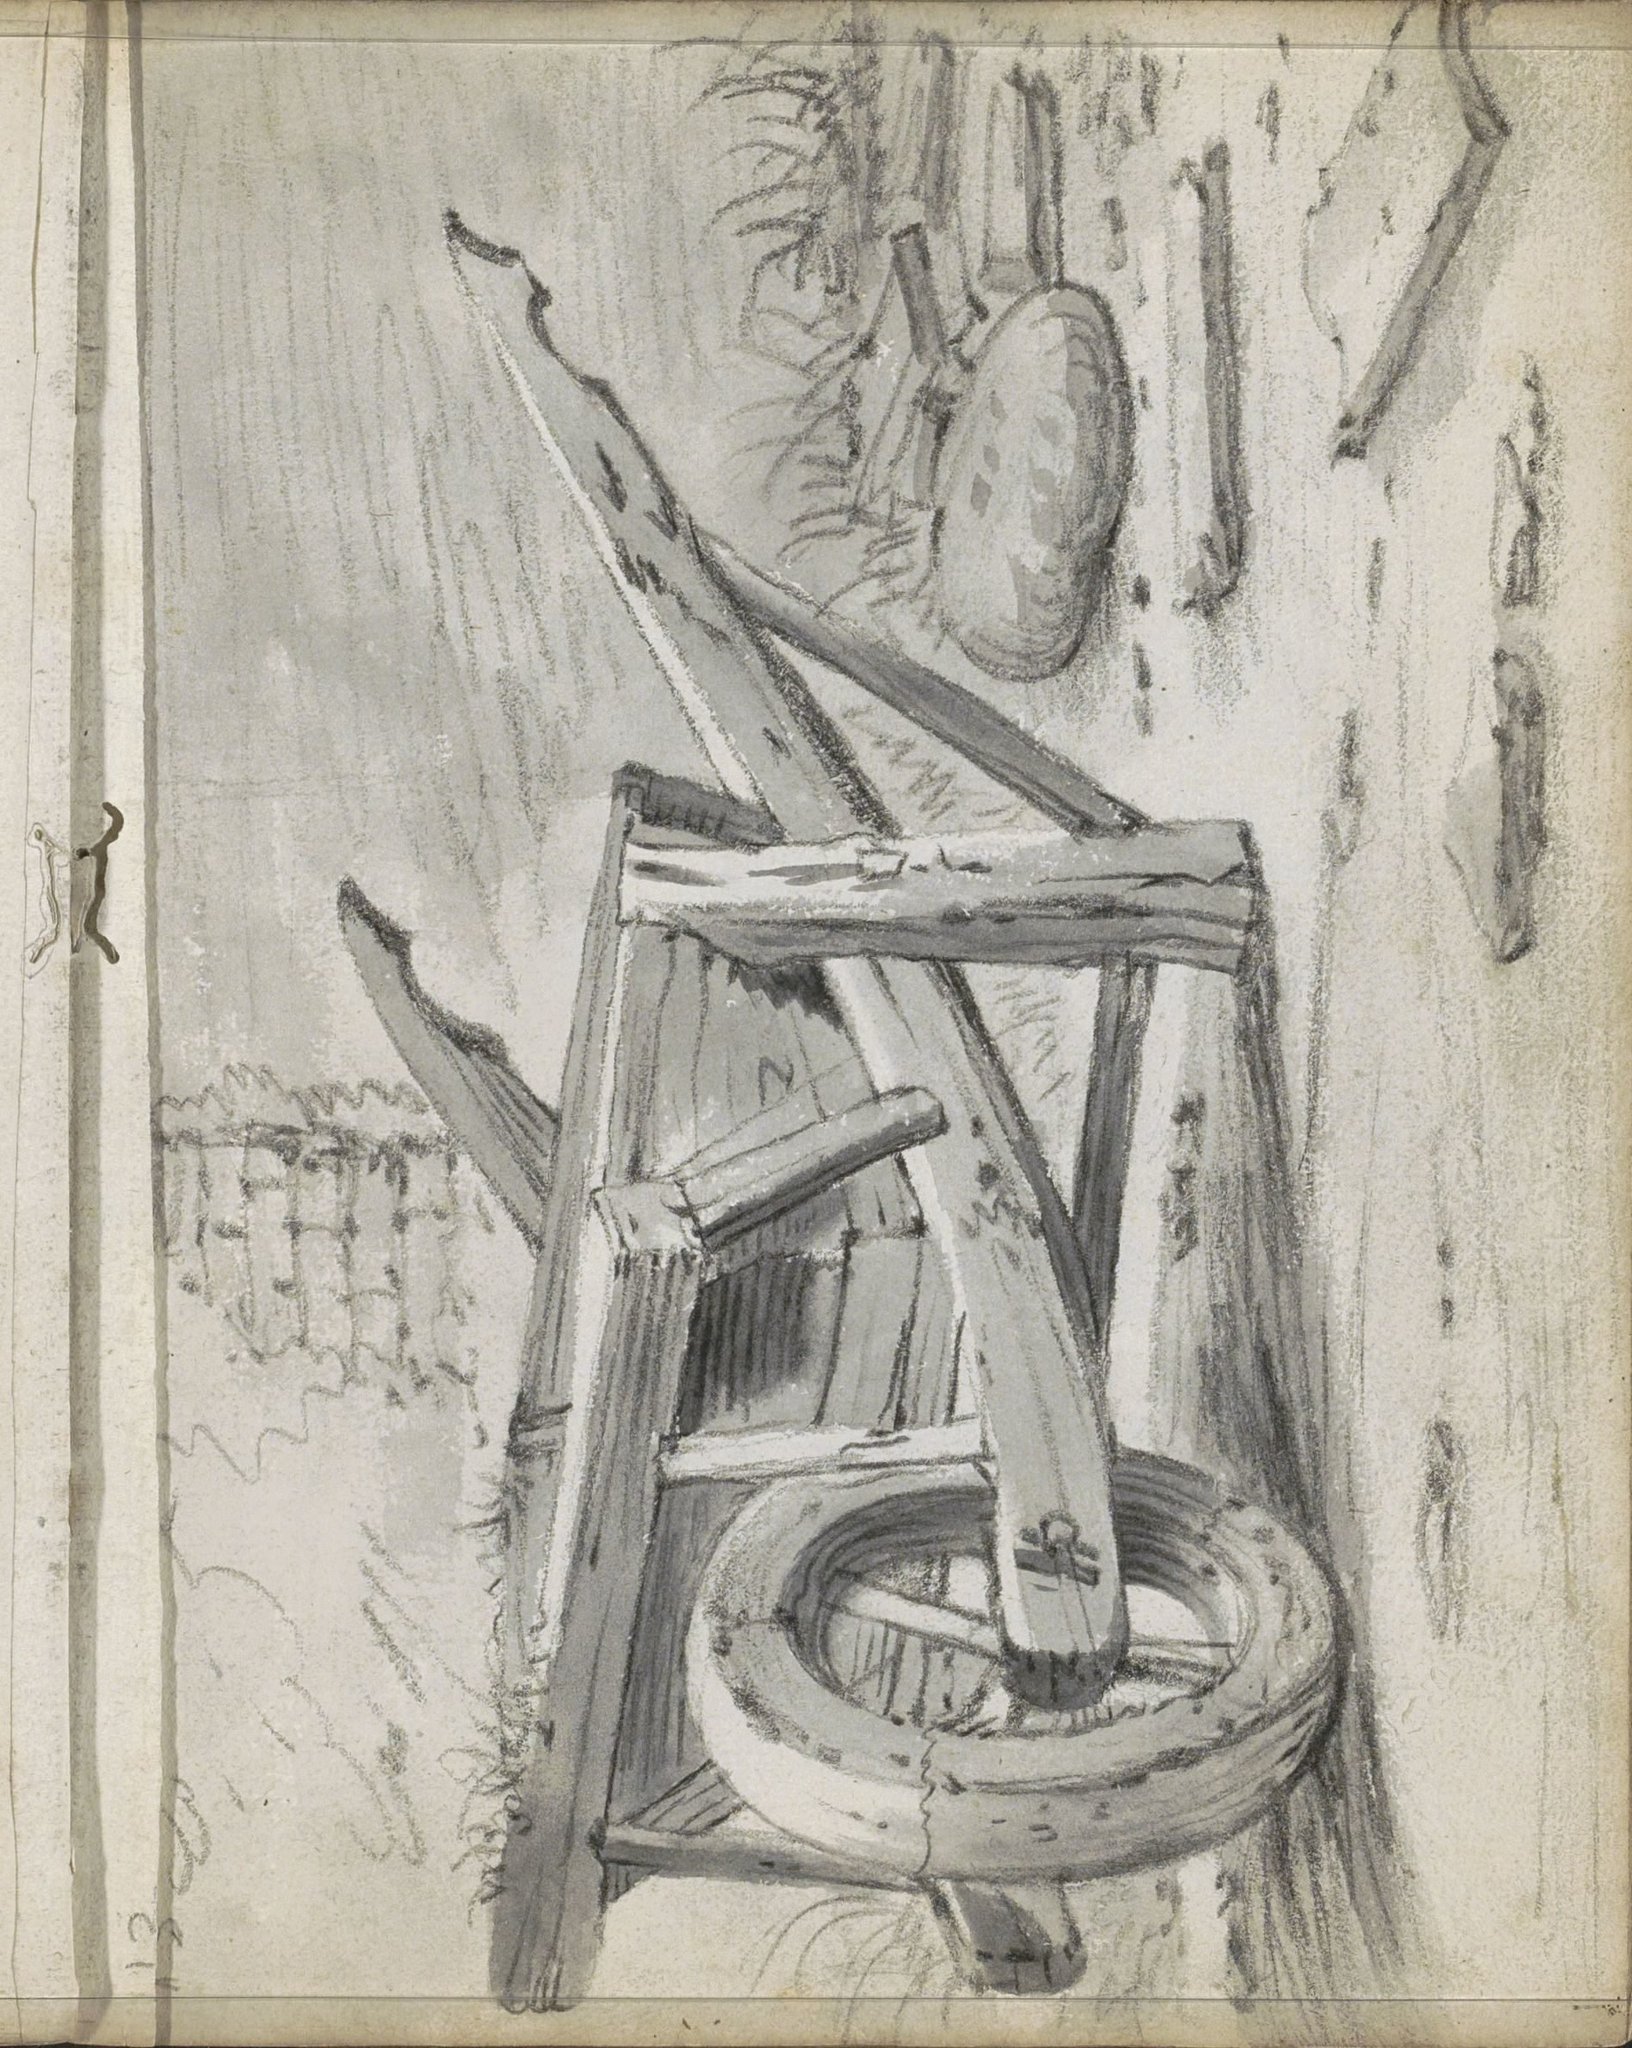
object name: sketchbook leaf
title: Handkar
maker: cornelis saftleven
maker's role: draughtsman, painter, print maker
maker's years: 1607-1681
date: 1666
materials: chalk, ink, paper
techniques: brush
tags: hand-cart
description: Blad 13 recto uit een schetsboek met 49 bladen.